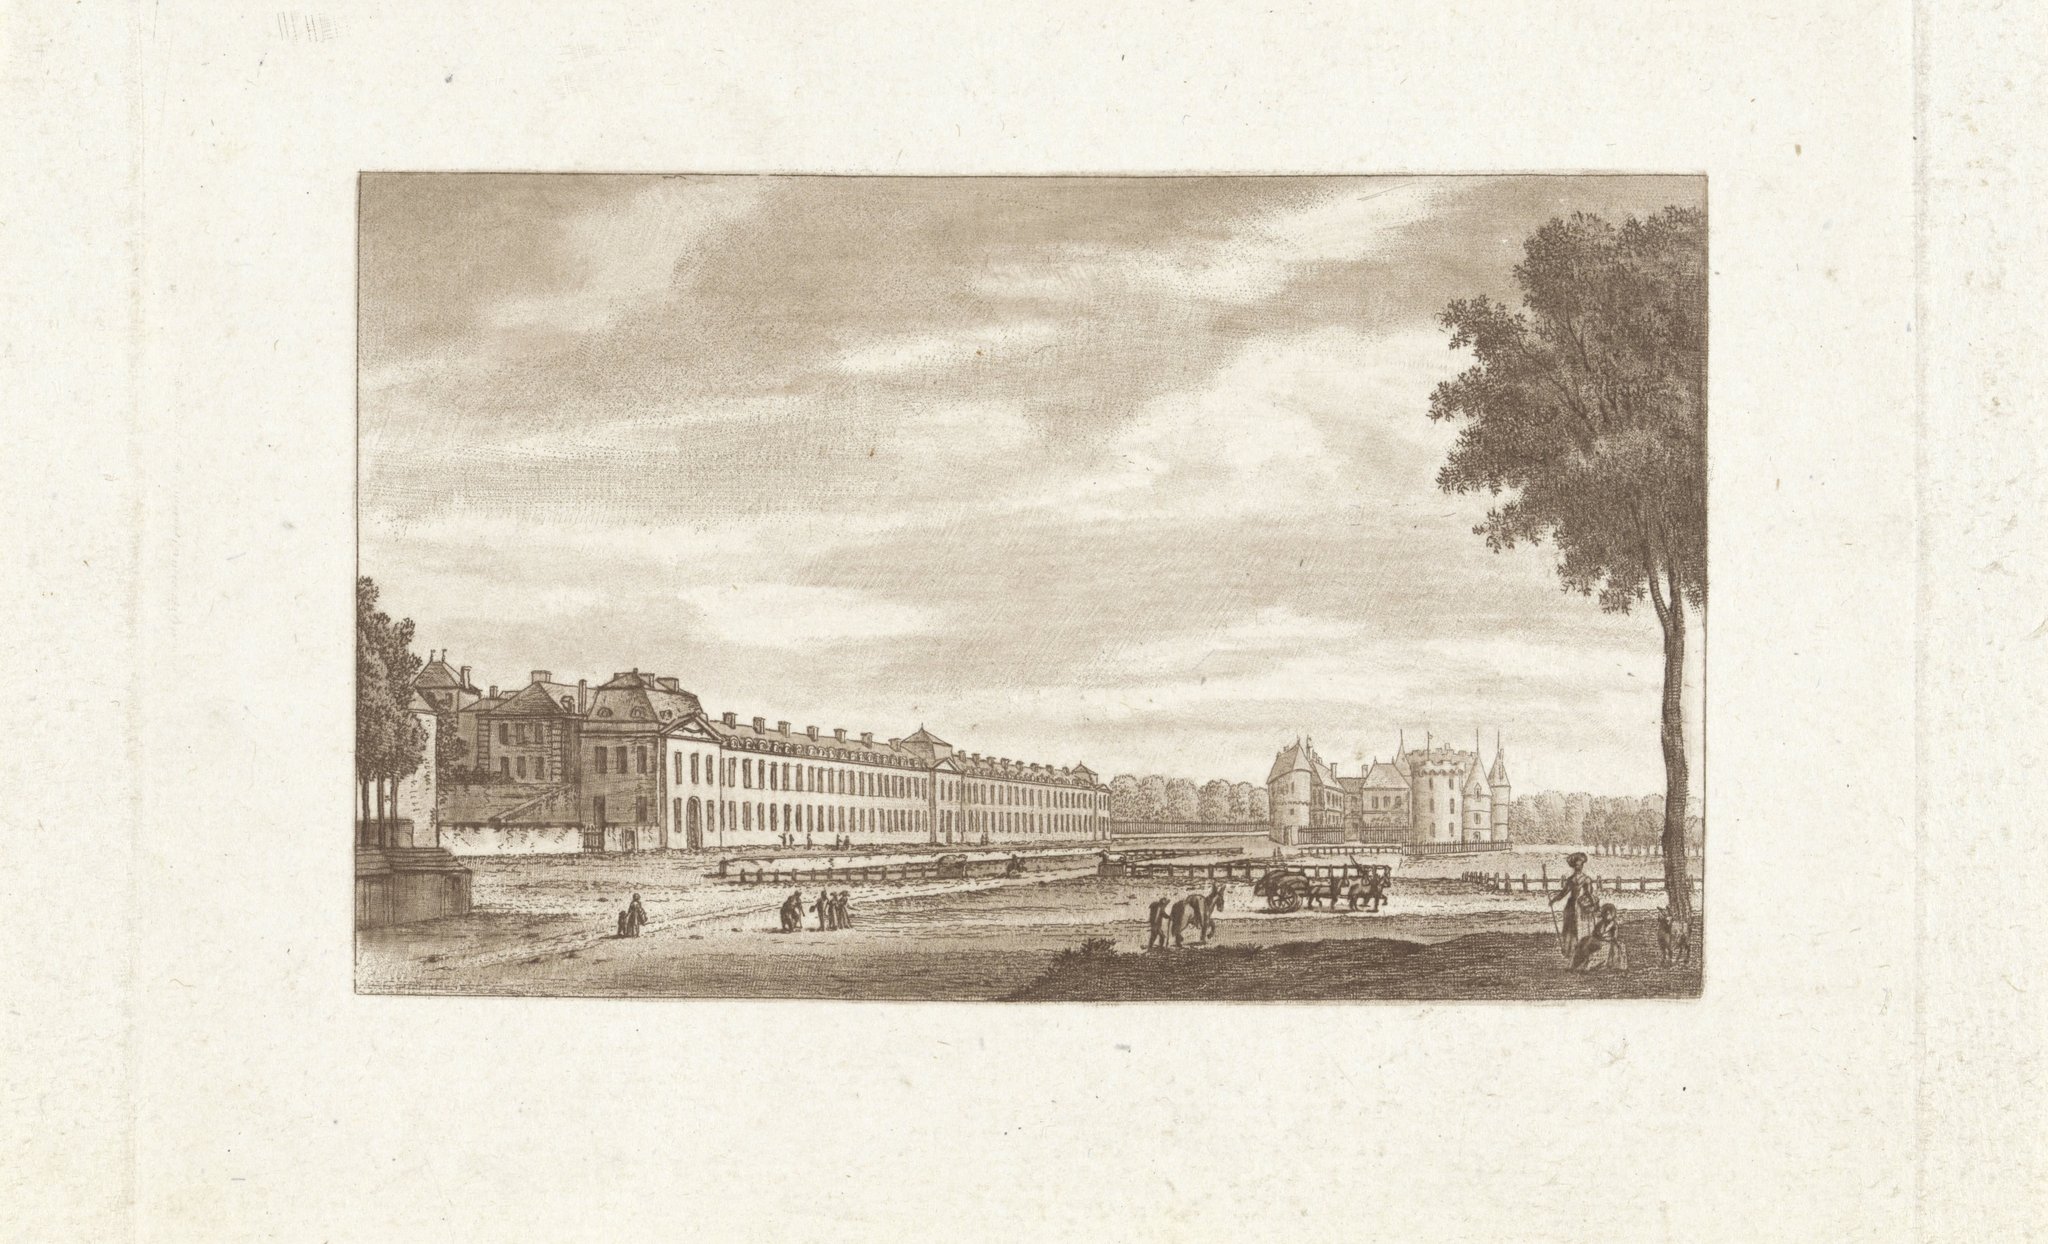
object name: print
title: Gezicht op Rambouillet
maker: hendrik schwegman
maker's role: draughtsman, print maker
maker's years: 1761-1816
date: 1771-1816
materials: paper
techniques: etching, roulette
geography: haarlem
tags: castle, village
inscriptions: collector's mark: Lugt 2228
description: Gezicht op Rambouillet met rechts het kasteel van Rambouillet.